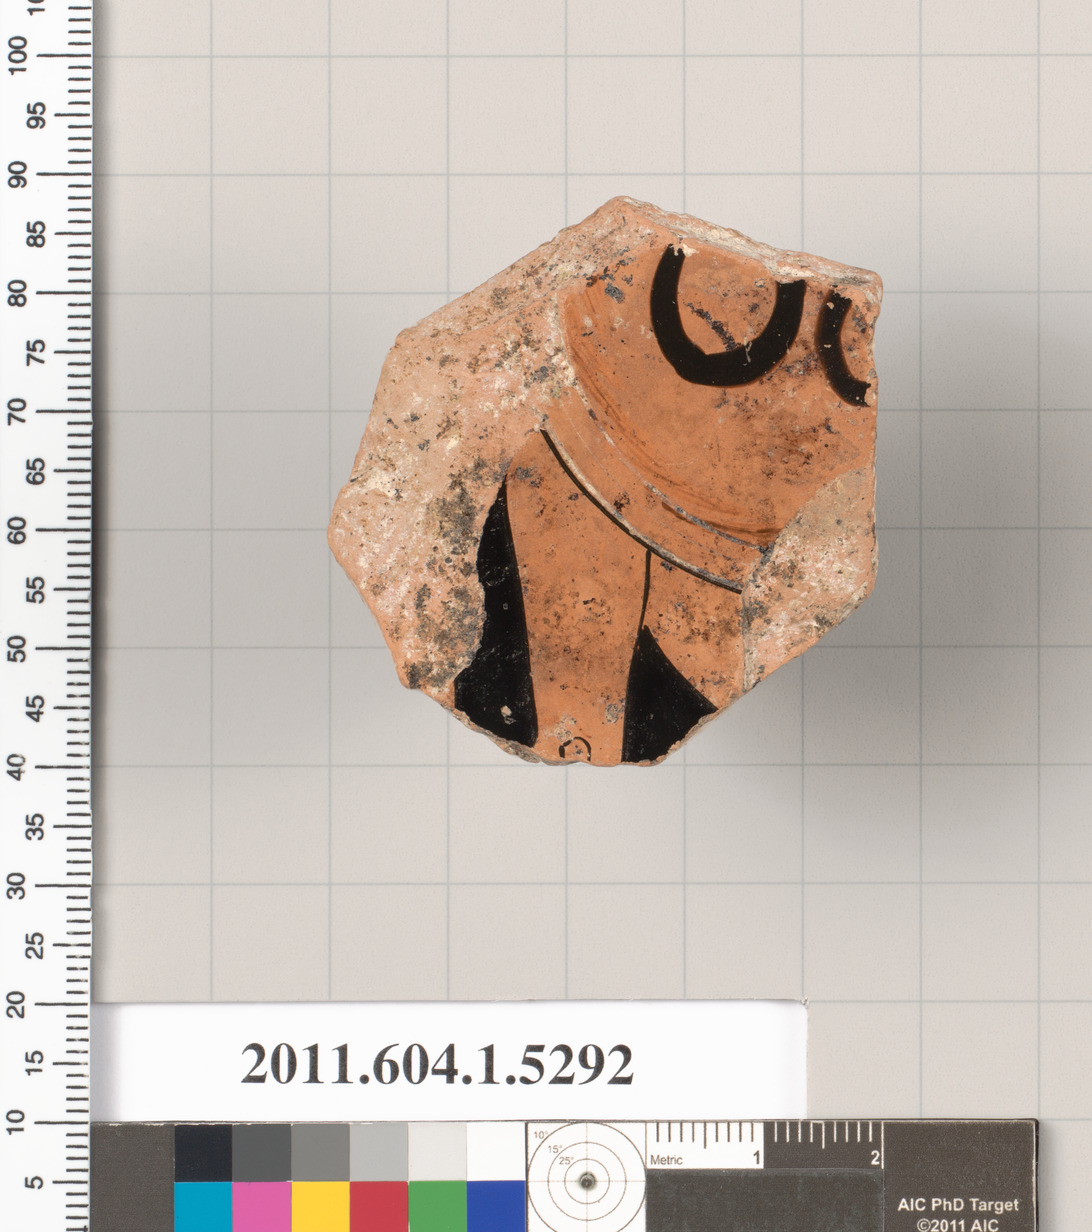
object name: kylix fragment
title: Terracotta fragment of a kylix (drinking cup)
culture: greek, attic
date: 500-480 BCE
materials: terracotta